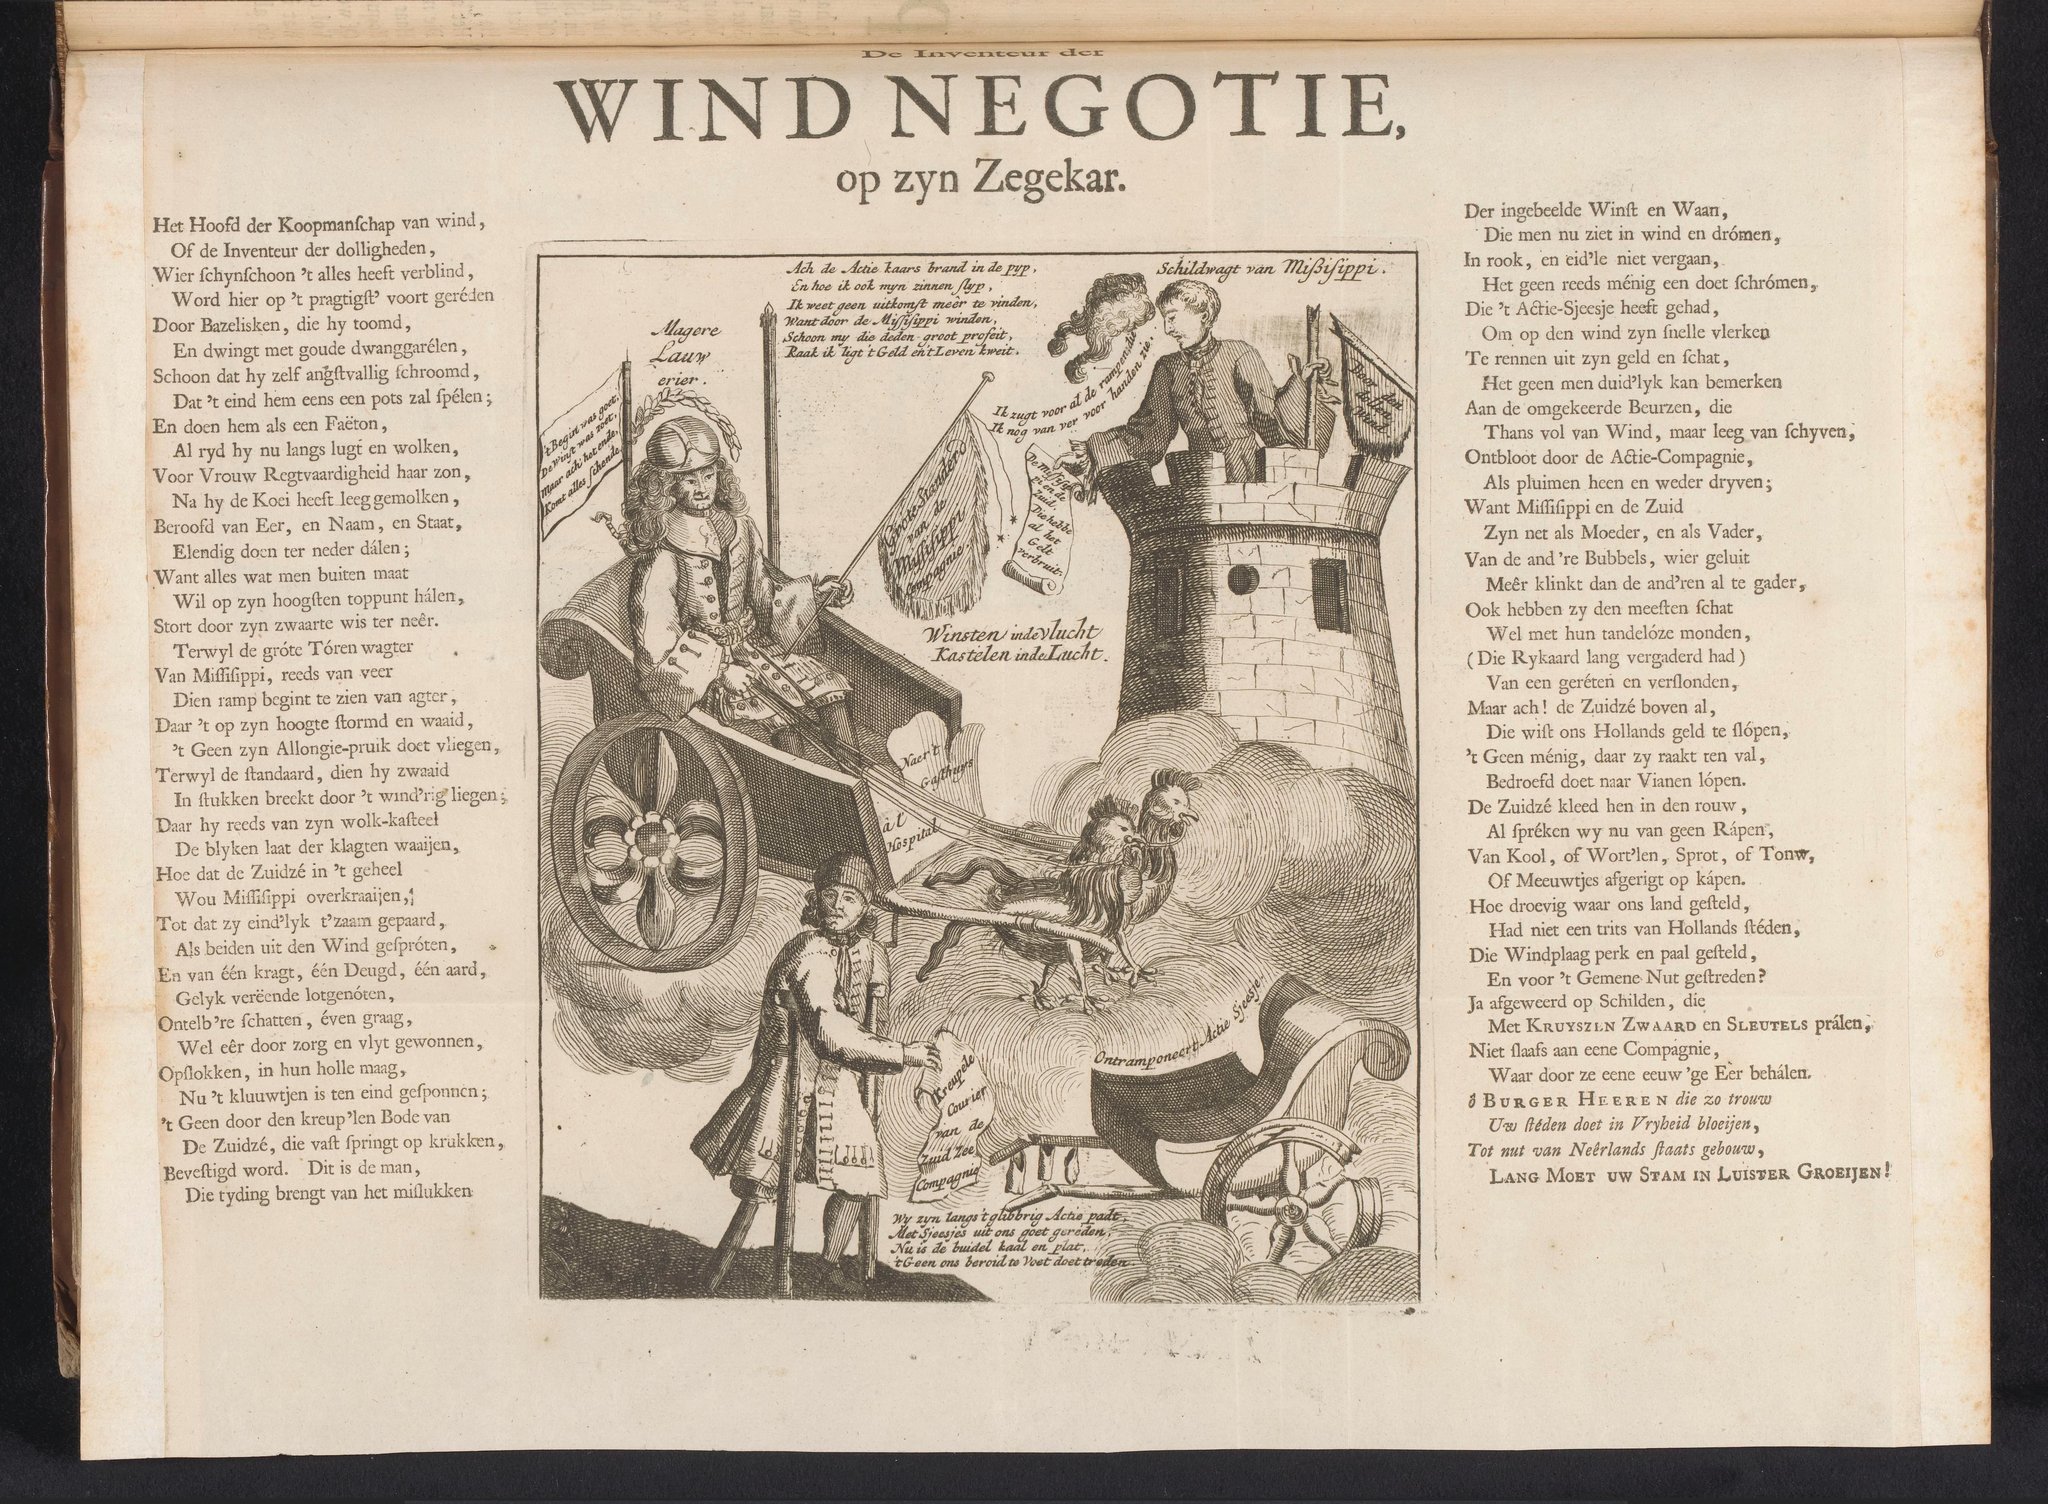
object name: cartoon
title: John Law, de uitvinder van de windnegotie, in zijn zegekar, 1720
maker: Anonymous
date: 1706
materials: paper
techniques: engraving, etching, letterpress printing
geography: northern netherlands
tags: chariot, triumphal car, person with a physical disability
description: John Law, de uitvinder van de windnegotie, in zijn zegekar getrokken door twee Franse hanen. Rechts de schildwacht van de Mississippi in een toren, op de voorgrond de 'kreupele koerier' van de Zuidzee-Compagnie. Gedrukt op het blad aan weerszijden van de plaat een vers in twee kolommen. Prent in de gebonden eerste uitgave (304 B 11) van Het Groote Tafereel der Dwaasheid met spotprenten op de Windhandel of Actiehandel van 1720.